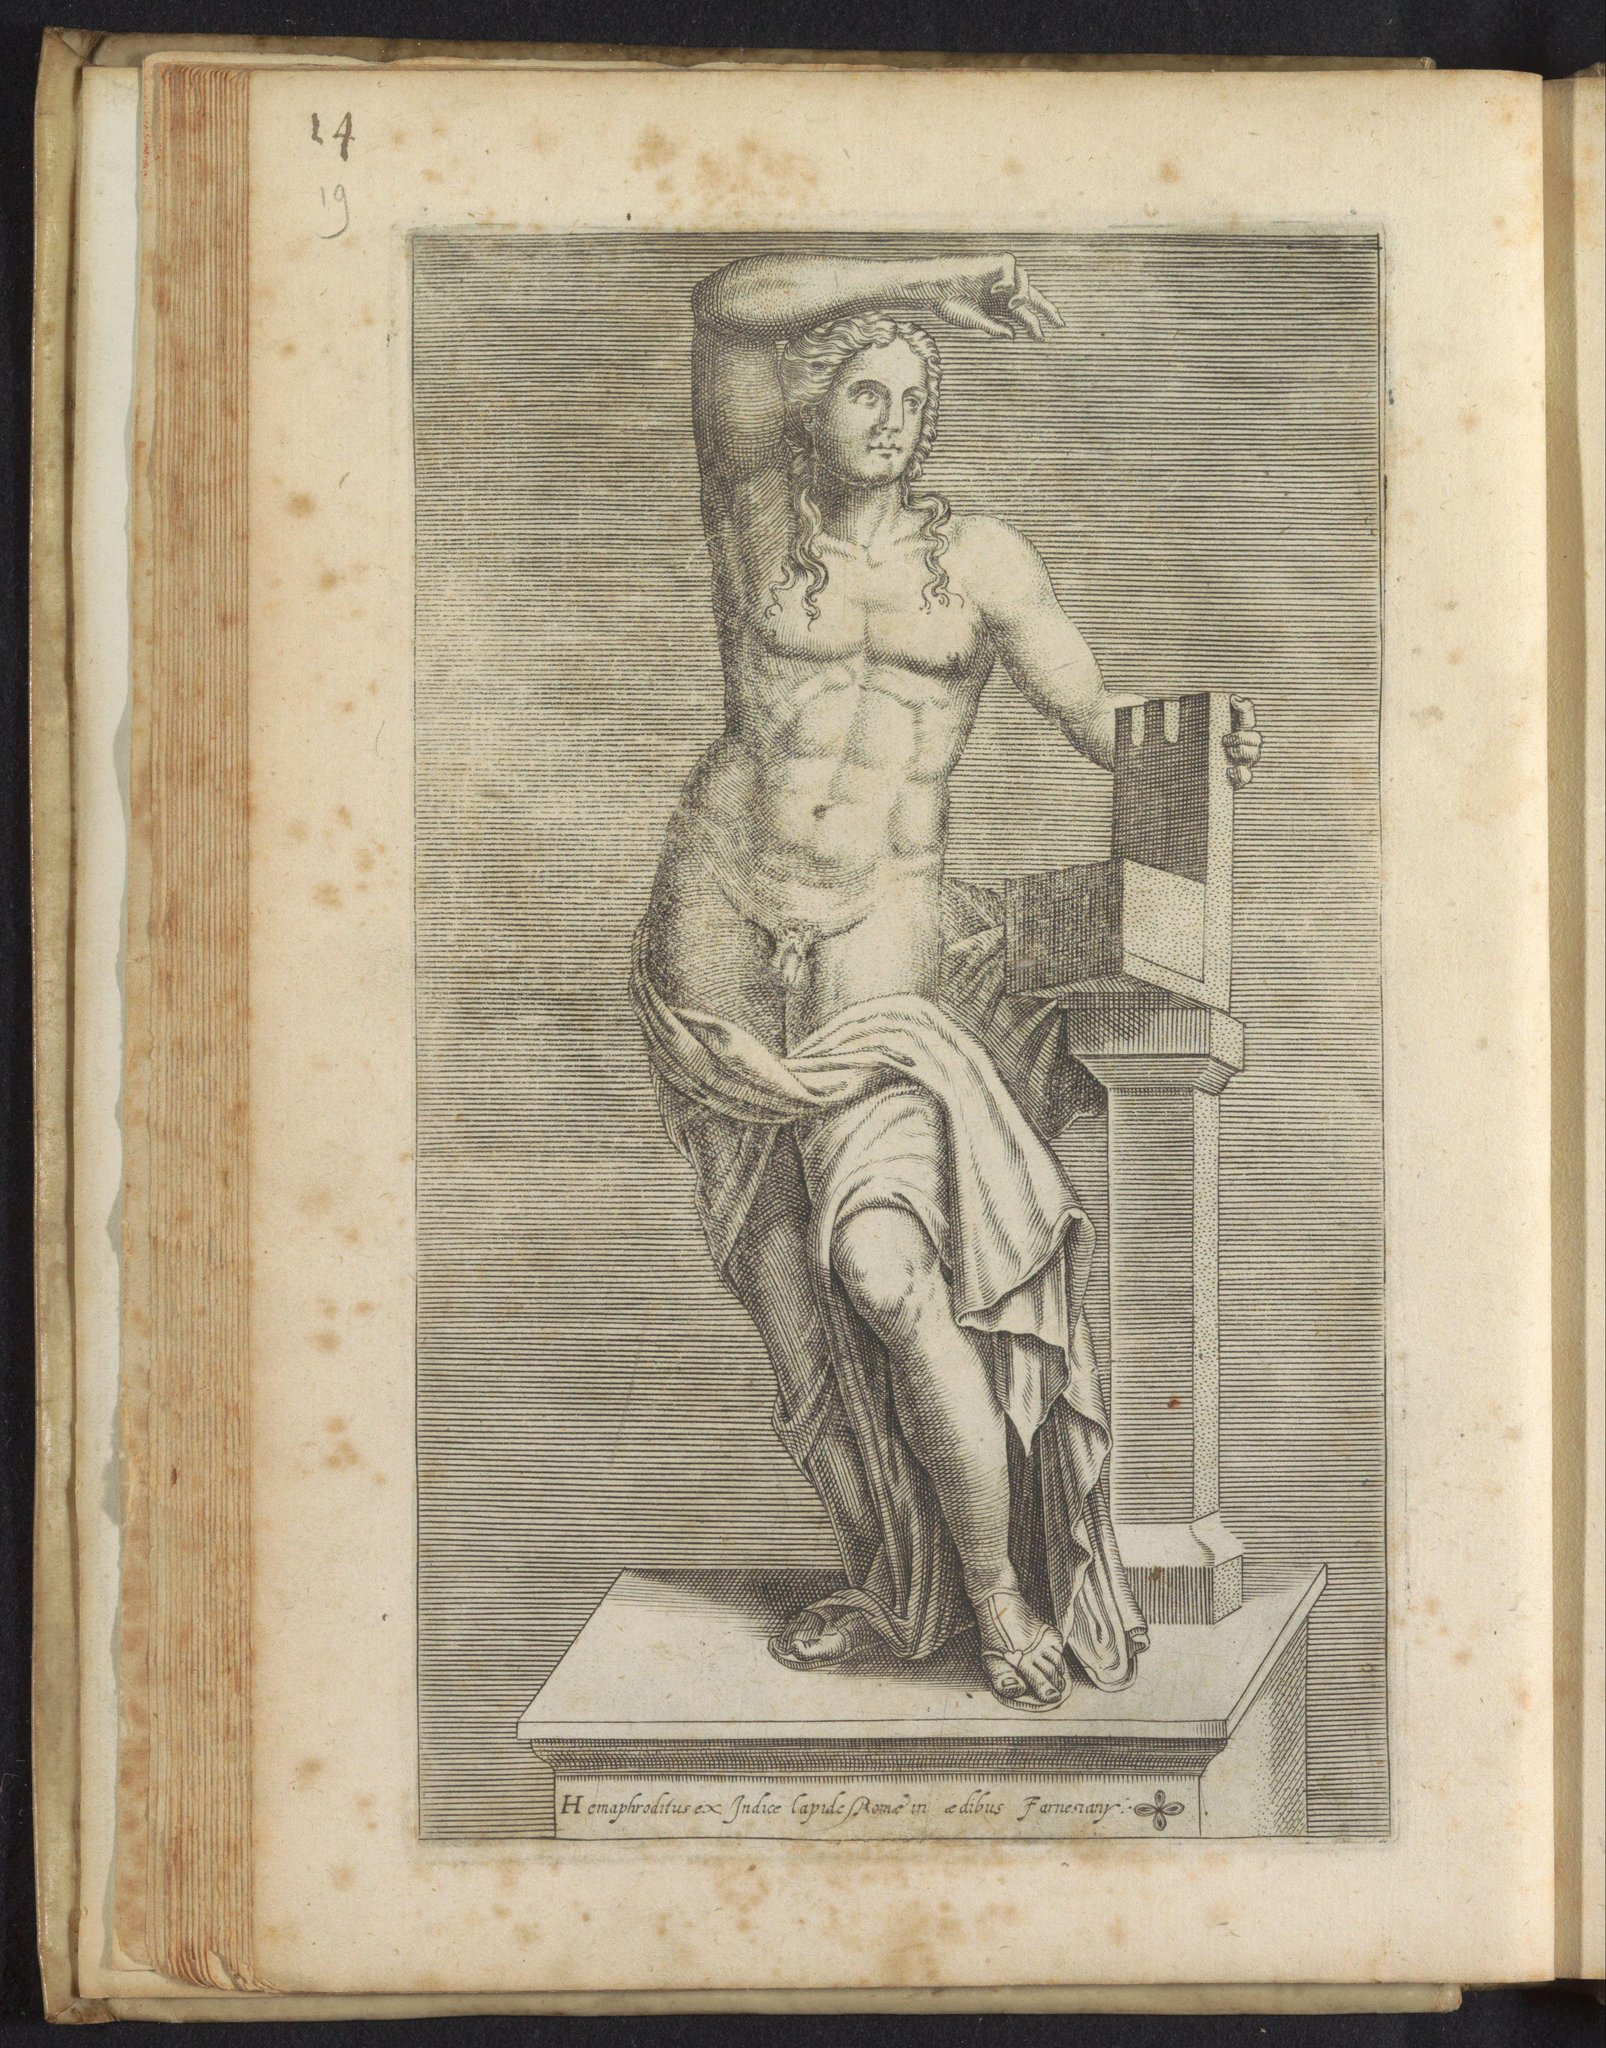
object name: print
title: Sculptuur van Hermafroditus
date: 1584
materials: paper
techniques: engraving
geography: rome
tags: (story of) apollo (phoebus), (story of) hermaphroditus, piece of sculpture, reproduction of a piece of sculpture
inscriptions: number: ‘14’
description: Beeld van een mannelijk naakt met een arm boven het hoofd. In de inscriptie wordt deze figuur geïnterpreteerd als Hermaphroditus, maar de figuur lijkt sterk op het type Apollo Lyceus. Prent maakt deel uit van een album.